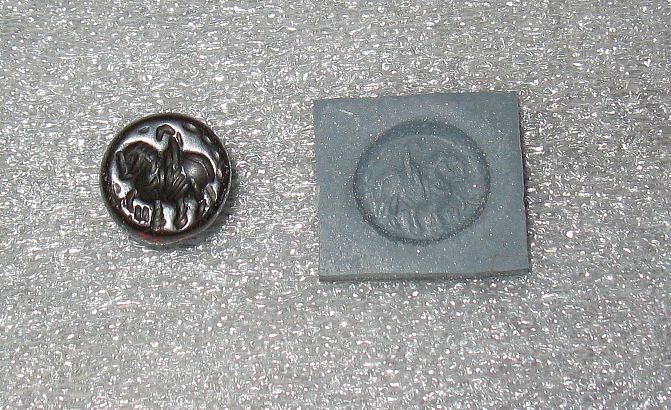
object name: stamp seal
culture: sasanian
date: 201-700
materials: mineral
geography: iran or mesopotamia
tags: horses